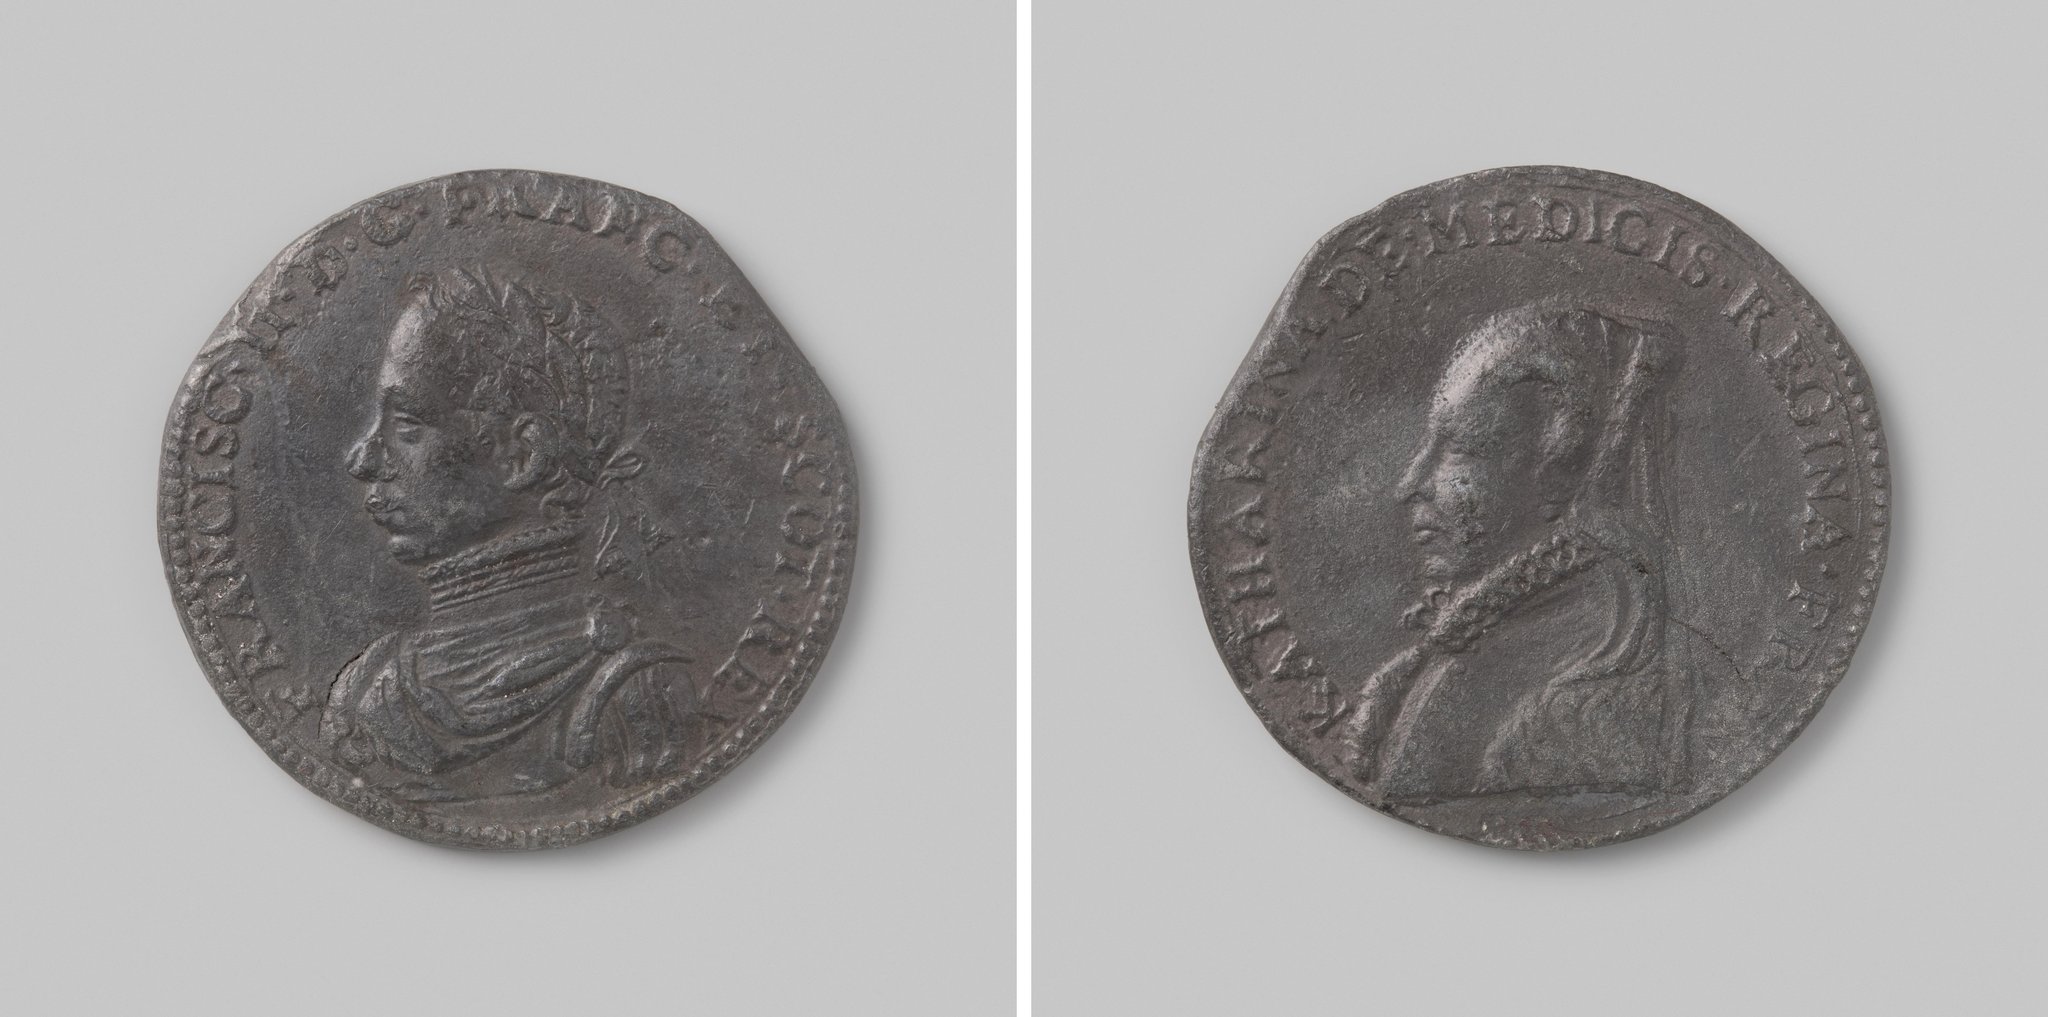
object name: history medal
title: Catharina de' Medici en Frans II, koning van Frankrijk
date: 1559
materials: lead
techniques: casting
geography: paris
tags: paris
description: Loden penning. Voorzijde: borststuk jongeman met lauwerkrans binnen omschrift. Keerzijde: borststuk vrouw binnen omschrift